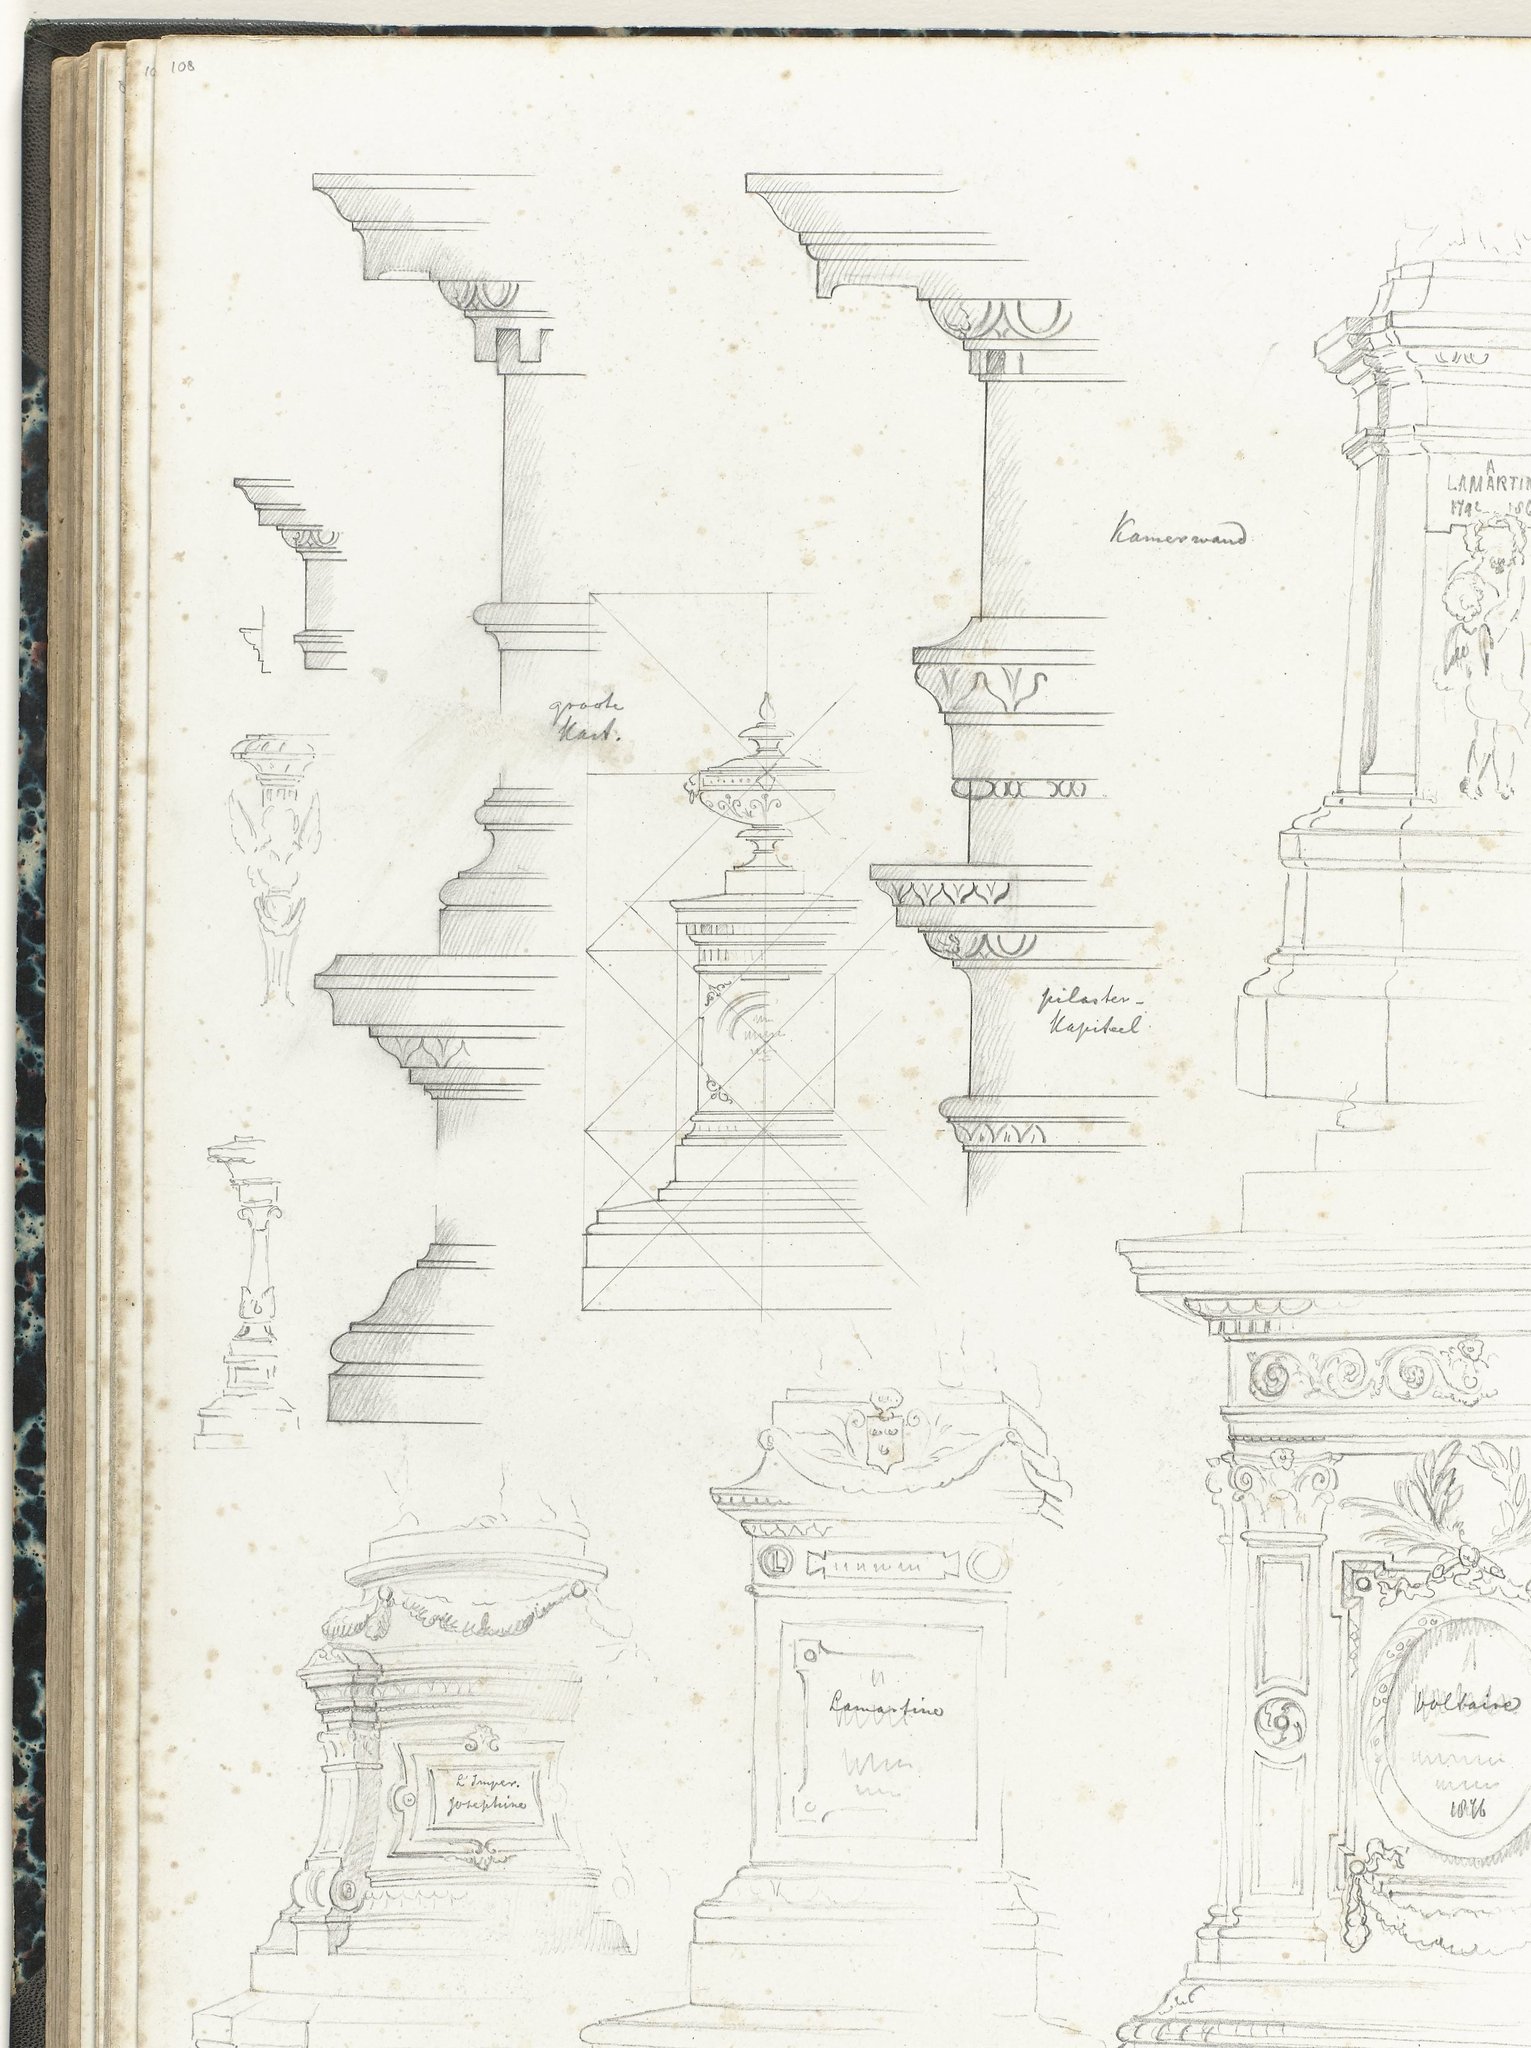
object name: drawing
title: Kapitelen en voetstukken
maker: Anonymous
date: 1866-1900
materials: paper, pencil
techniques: drawing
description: Rechtsboven een voetstuk met een putto die een krans vast heeft, rechtsonder een voetstuk met een ovaal waarin de tekst Voltaire 1876 staat. Bij een aantal objecten staat uitleg.